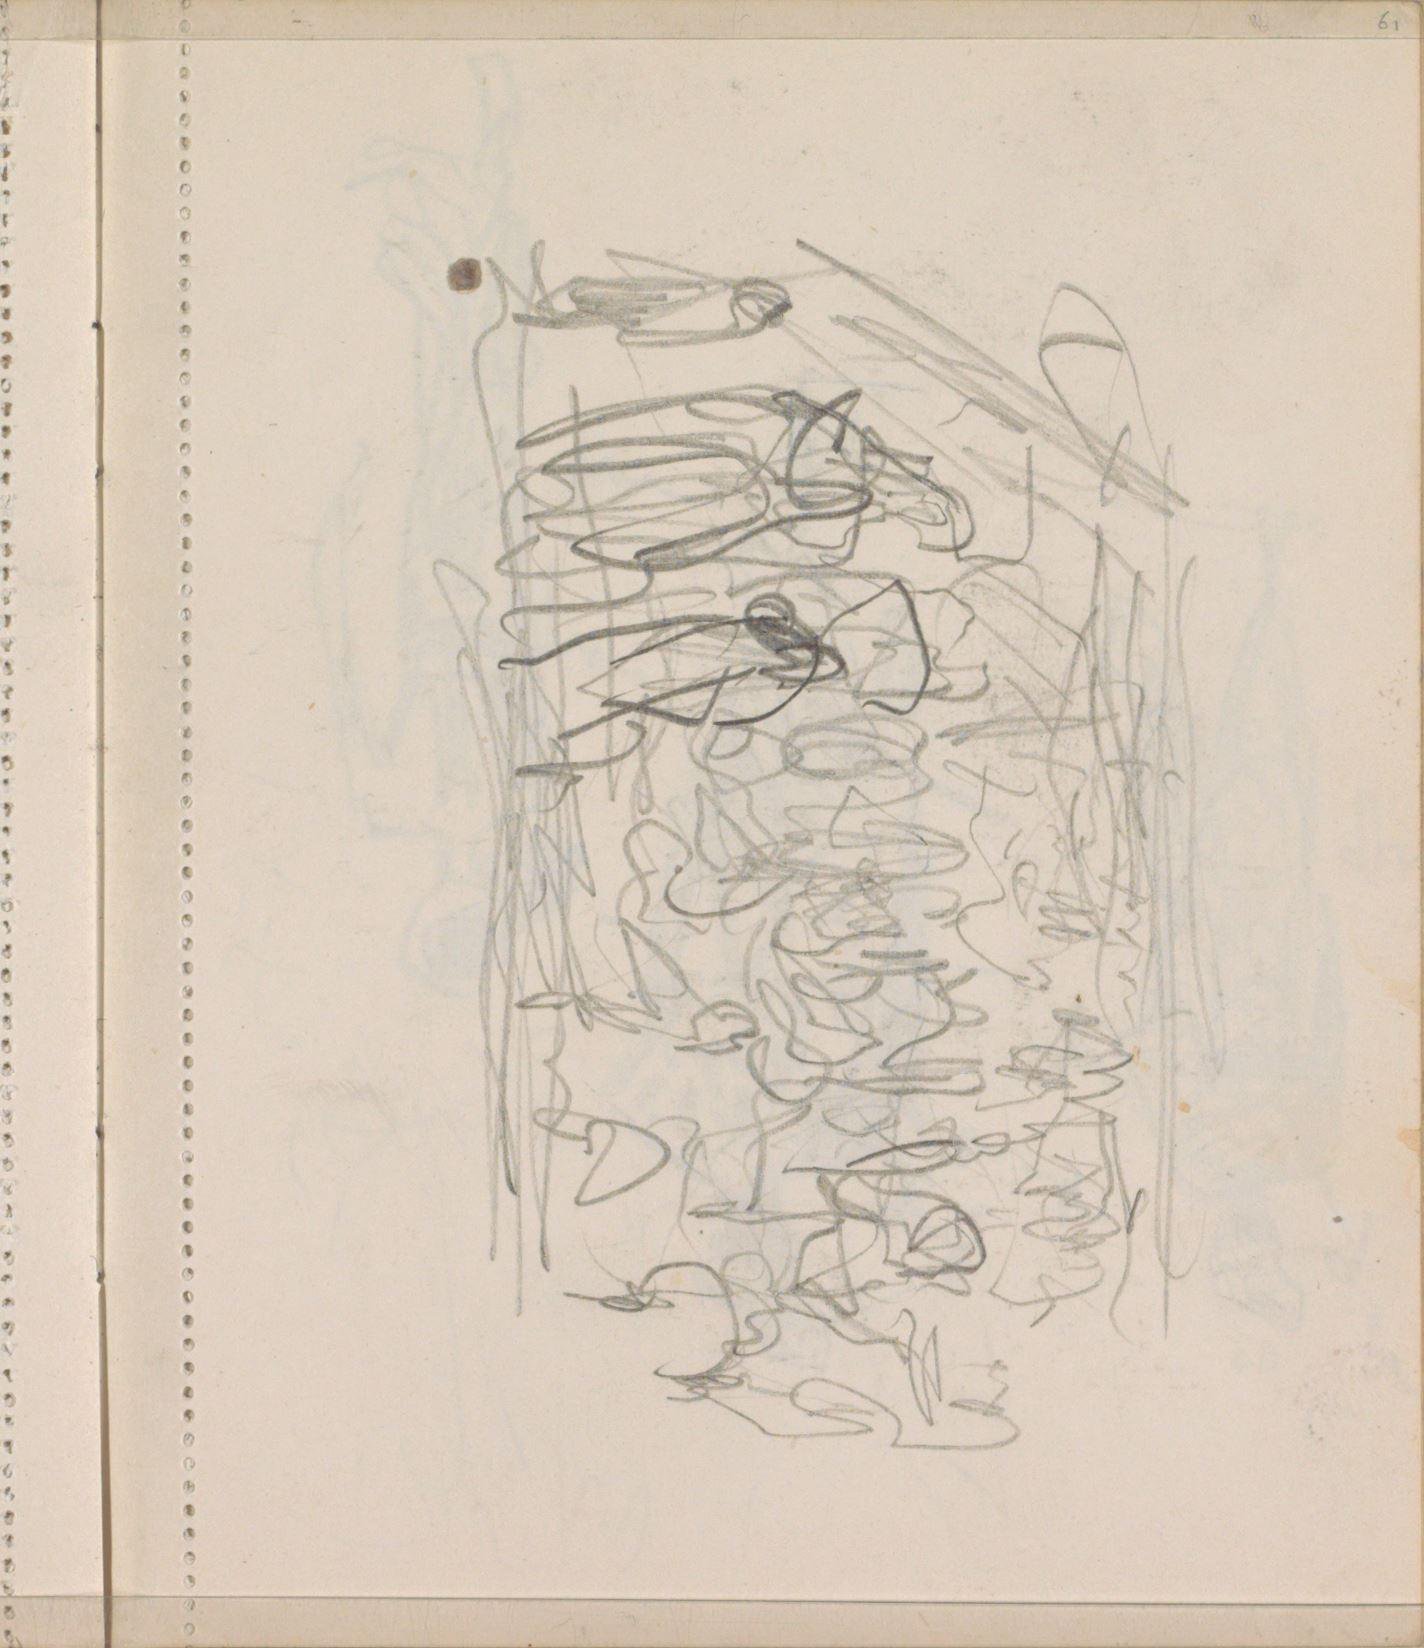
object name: sketchbook leaf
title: Studie, mogelijk een straat met figuren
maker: marius bauer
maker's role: draughtsman, print maker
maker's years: 1867-1932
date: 1925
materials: paper, pencil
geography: indonesia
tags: street (+ city(-scape) with figures, staffage)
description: Pagina 61 uit een schetsboek met 67 bladen.